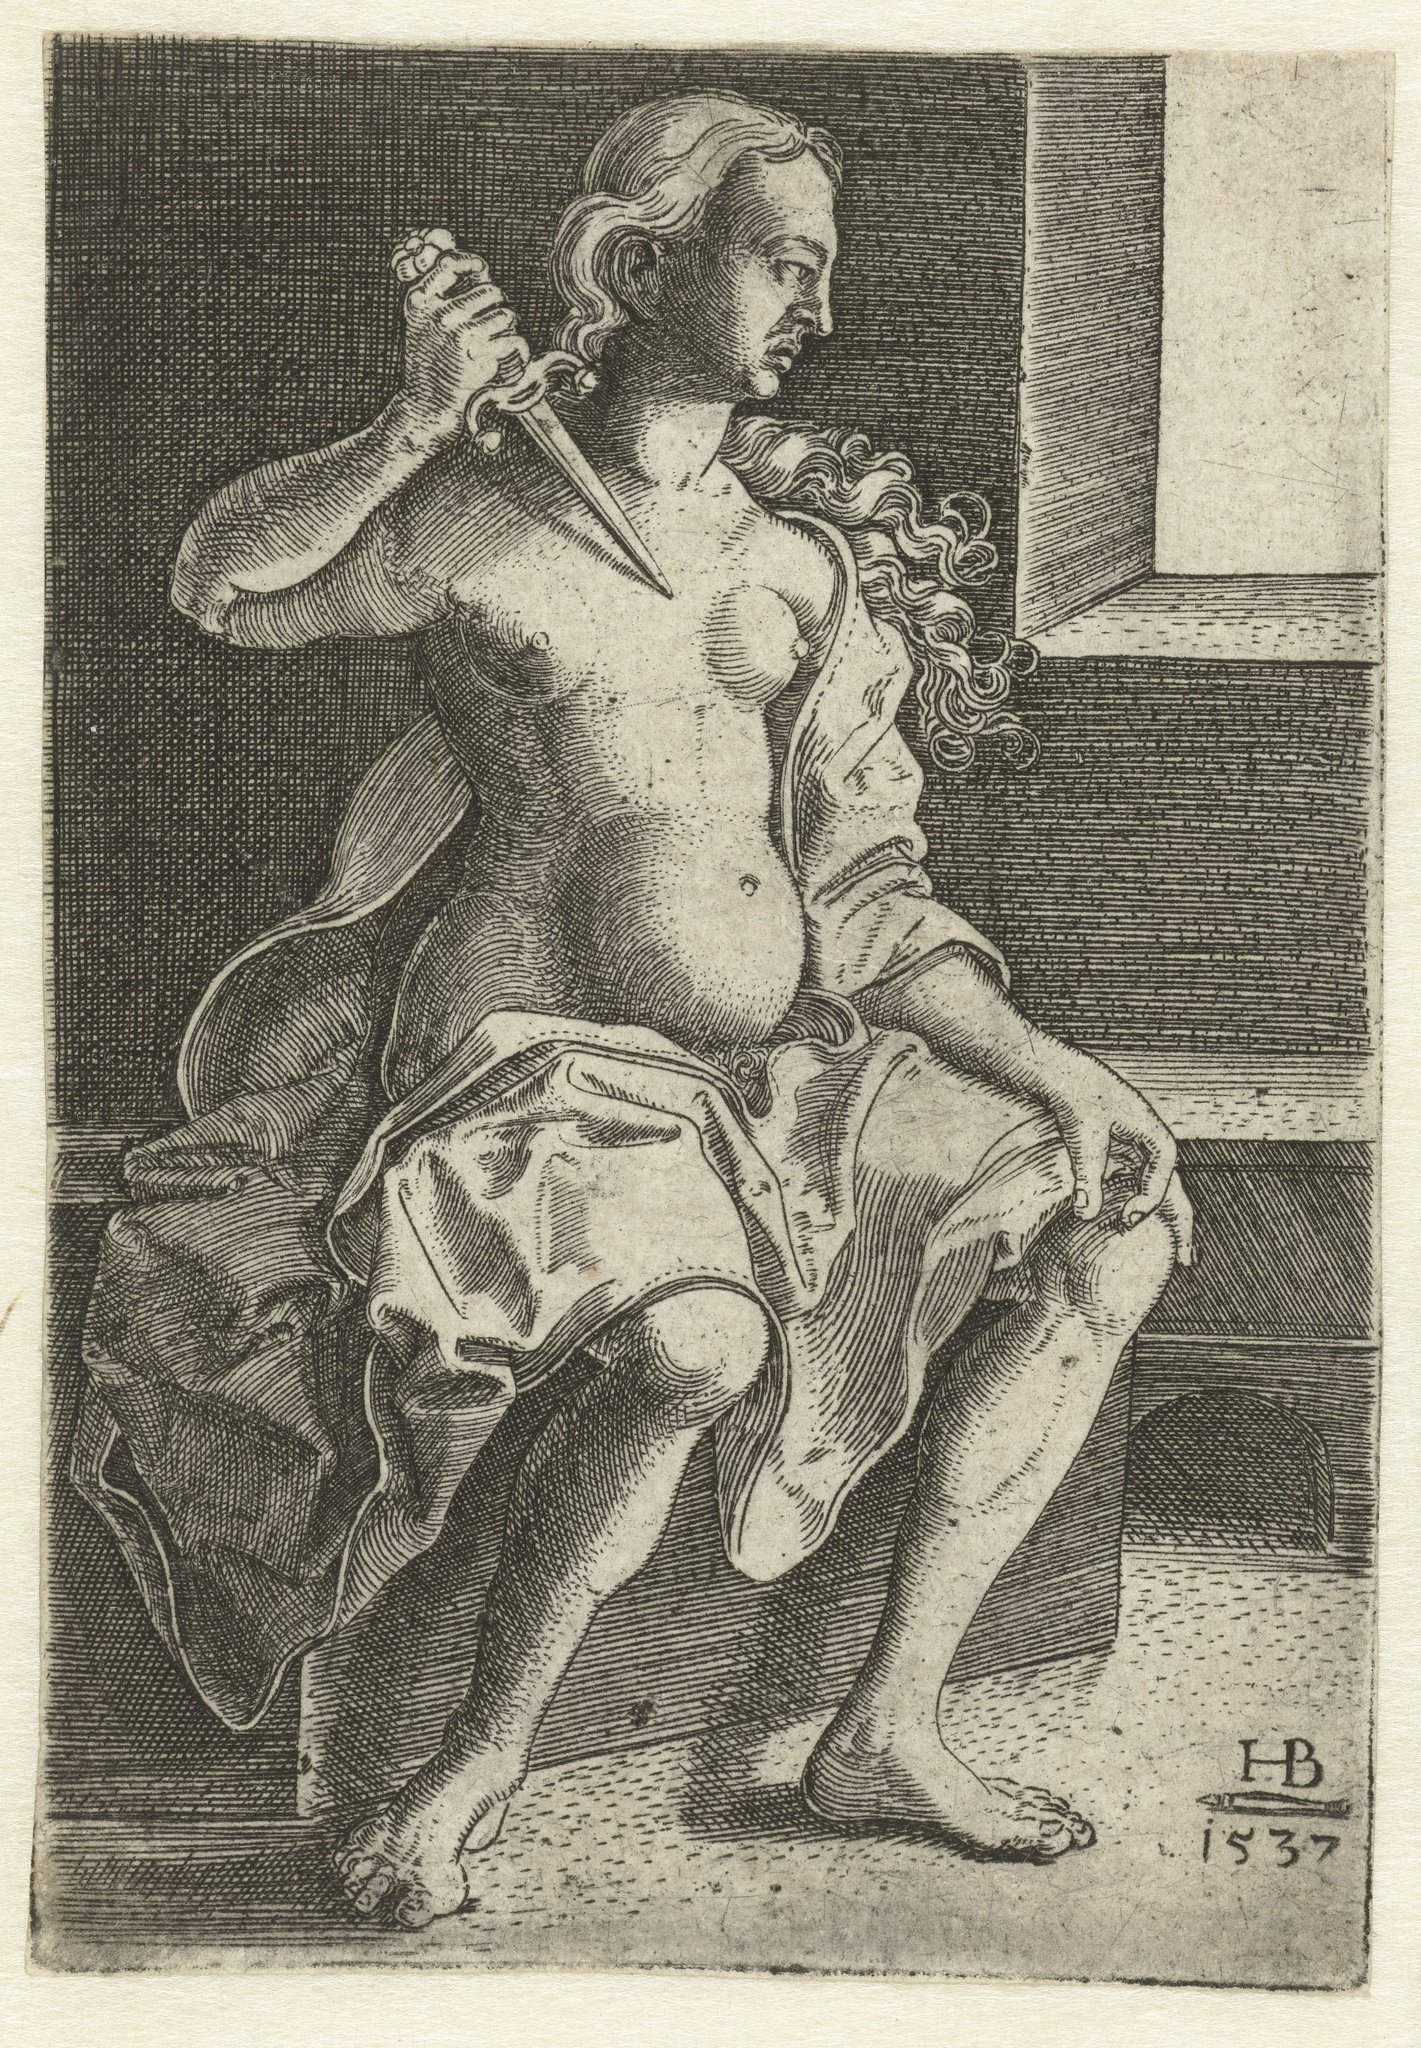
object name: print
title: Lucretia steekt mes in haar borst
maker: hans brosamer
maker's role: print maker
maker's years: 1500-1554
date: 1537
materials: paper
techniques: engraving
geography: fulda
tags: (story of) lucretia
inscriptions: collector's mark: Lugt 2228a